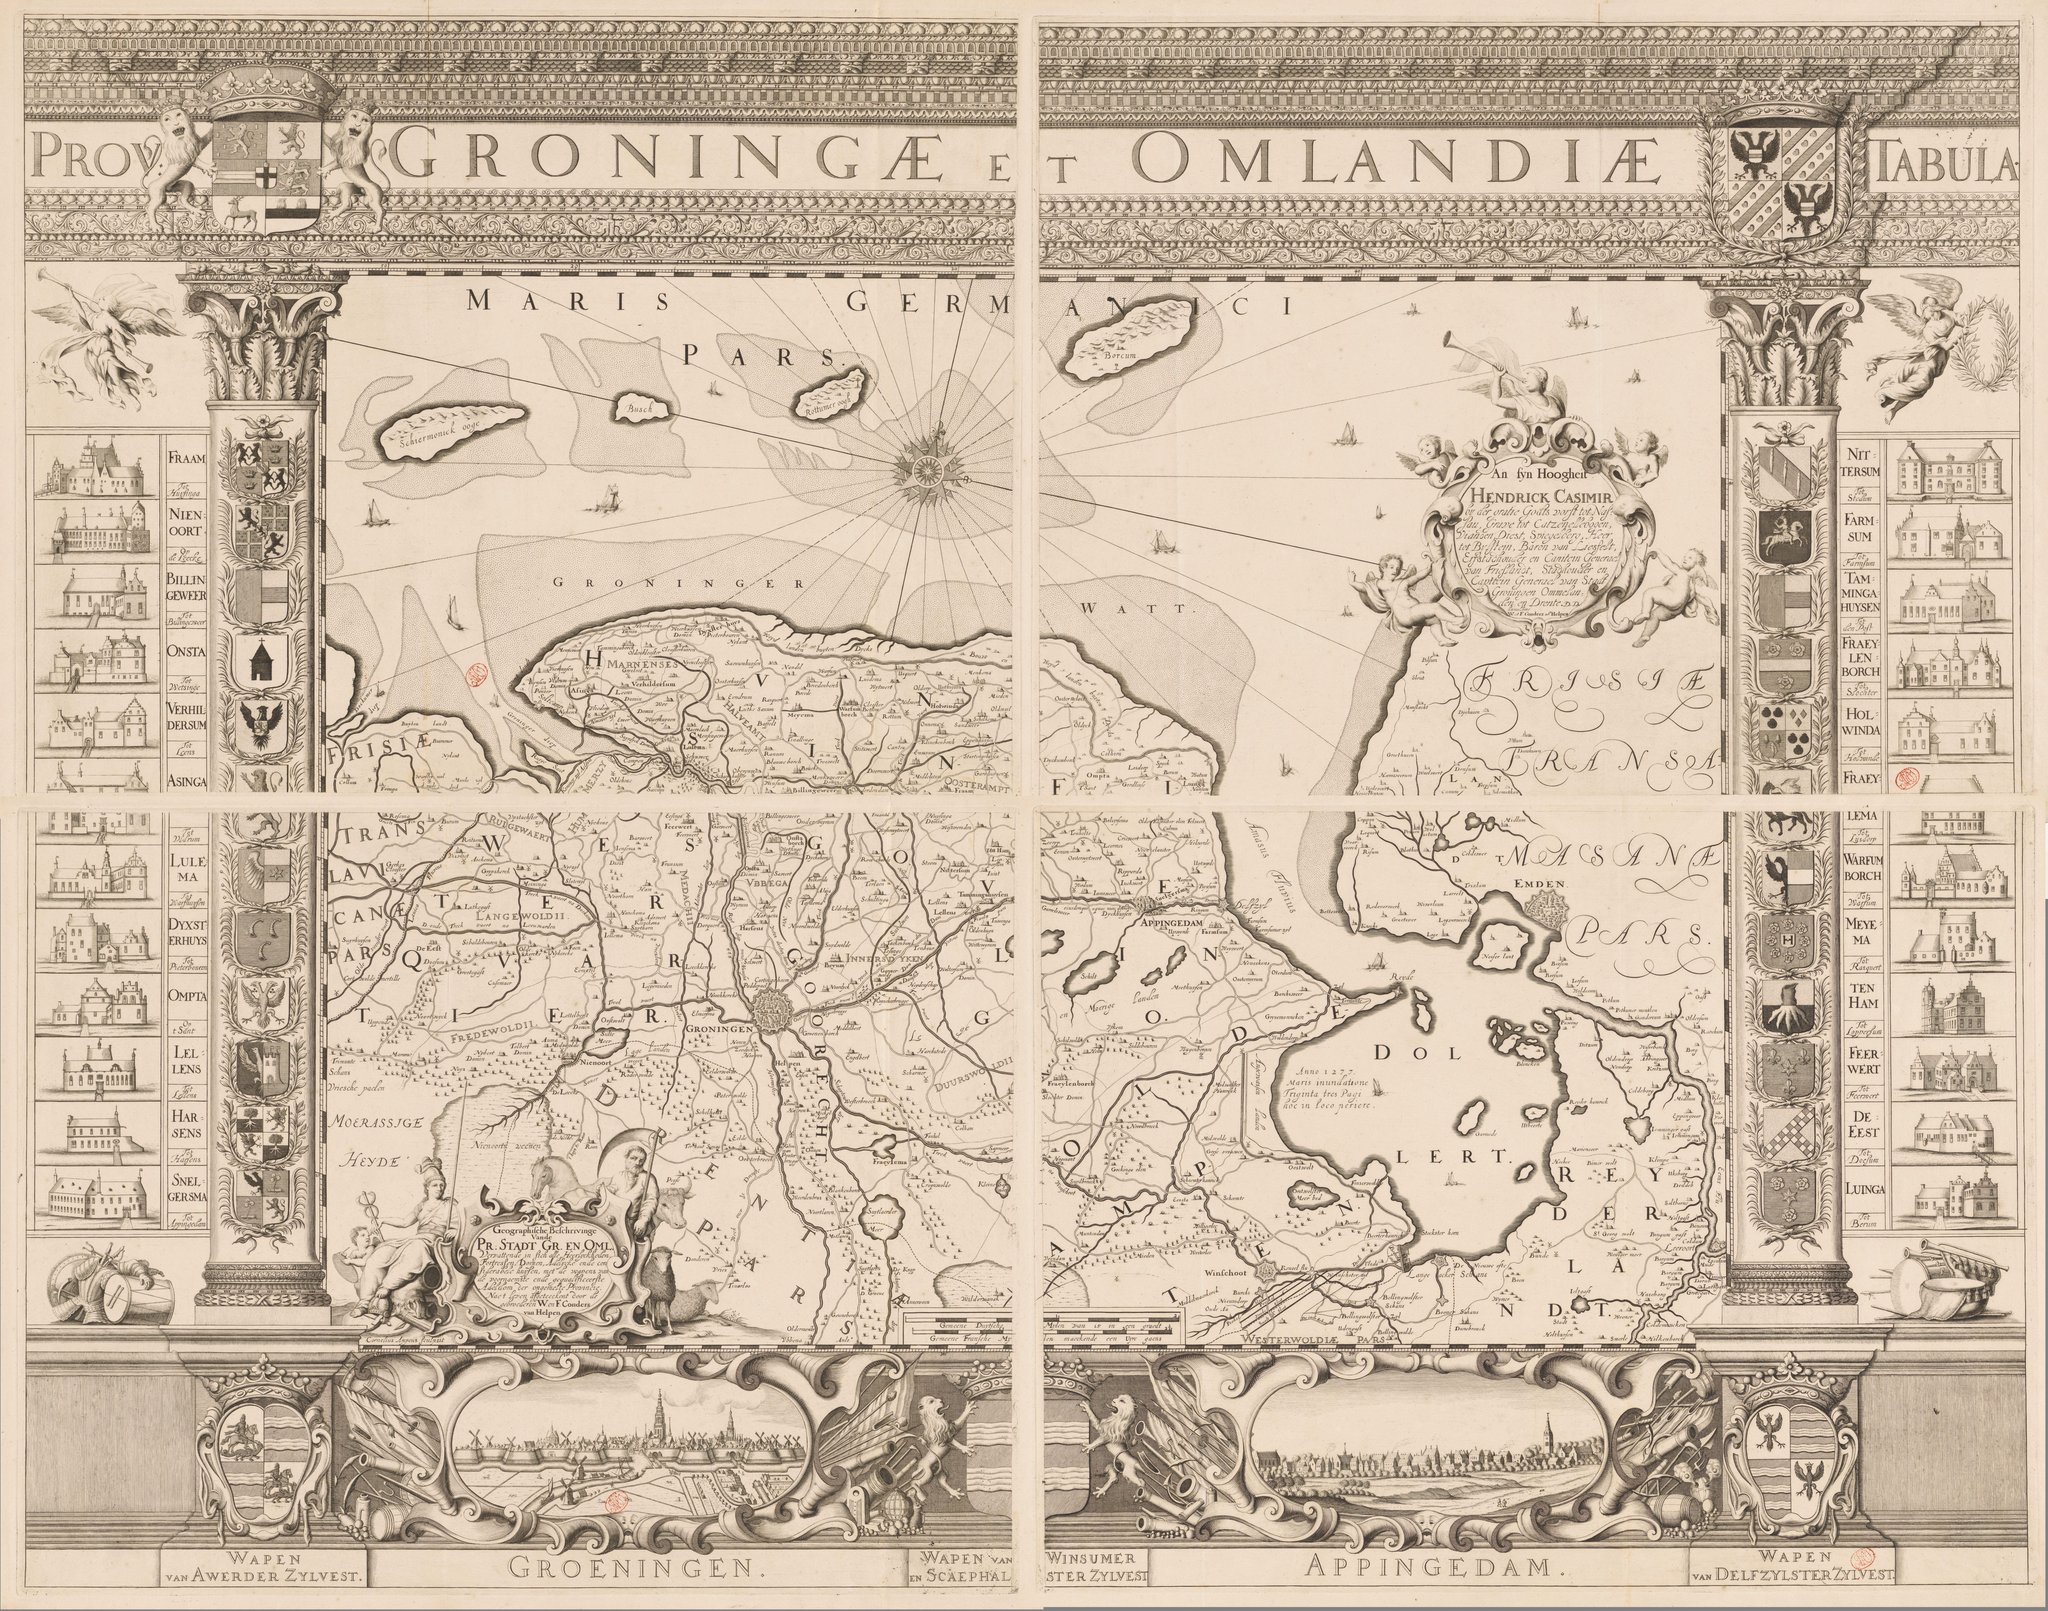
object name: map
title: Kaart van de provincie Groningen, bestaande uit vier delen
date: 1678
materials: paper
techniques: engraving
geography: leeuwarden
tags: coat of arms (as symbol of the state, etc.), city-view, and landscape with man-made constructions, maps of separate countries or regions, farmers, weapons, fame; 'fama', 'fama buona', 'fama chiara' (ripa), groningen (province)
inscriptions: collector's mark: Lugt 195, collector's mark: Lugt 2228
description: Op de kaart zelf linksonder de titelcartouche met daaromheen een putto, een vrouw met een helm op haar hoofd en een caduceus in haar hand, een landbouwer en vee. Onderaan in het midden twee schaalstokken: Gemeene Duytsche mylen van 15 in een graedt, Gemeene Fransche mylen maeckende een uyre gaens. Rechtsboven een cartouche met de opdracht, daaromheen putti en Fama. Op de sierrand linksboven het wapen van stadhouder Hendrik Casimir II van Nassau-Dietz, rechtsboven het wapen van de provincie Groningen. Helemaal links afbeeldingen van twaalf Groningse borgen, rechts daarvan een Korintische zuil met de bijhorende familiewapens. Helemaal rechts afbeeldingen van nog twaalf Groningse borgen, links daarvan een Korintische zuil met de bijhorende familiewapens. Onderaan de sierrand, van links naar rechts, het wapen van Aduarderzijlvest, een stadsgezicht van Groningen, het wapen van Winsumer en Schaphalsterzijlvest, een stadsgezicht van Appingedam en het Generale Zijlvest der Drie Delfzijlen.